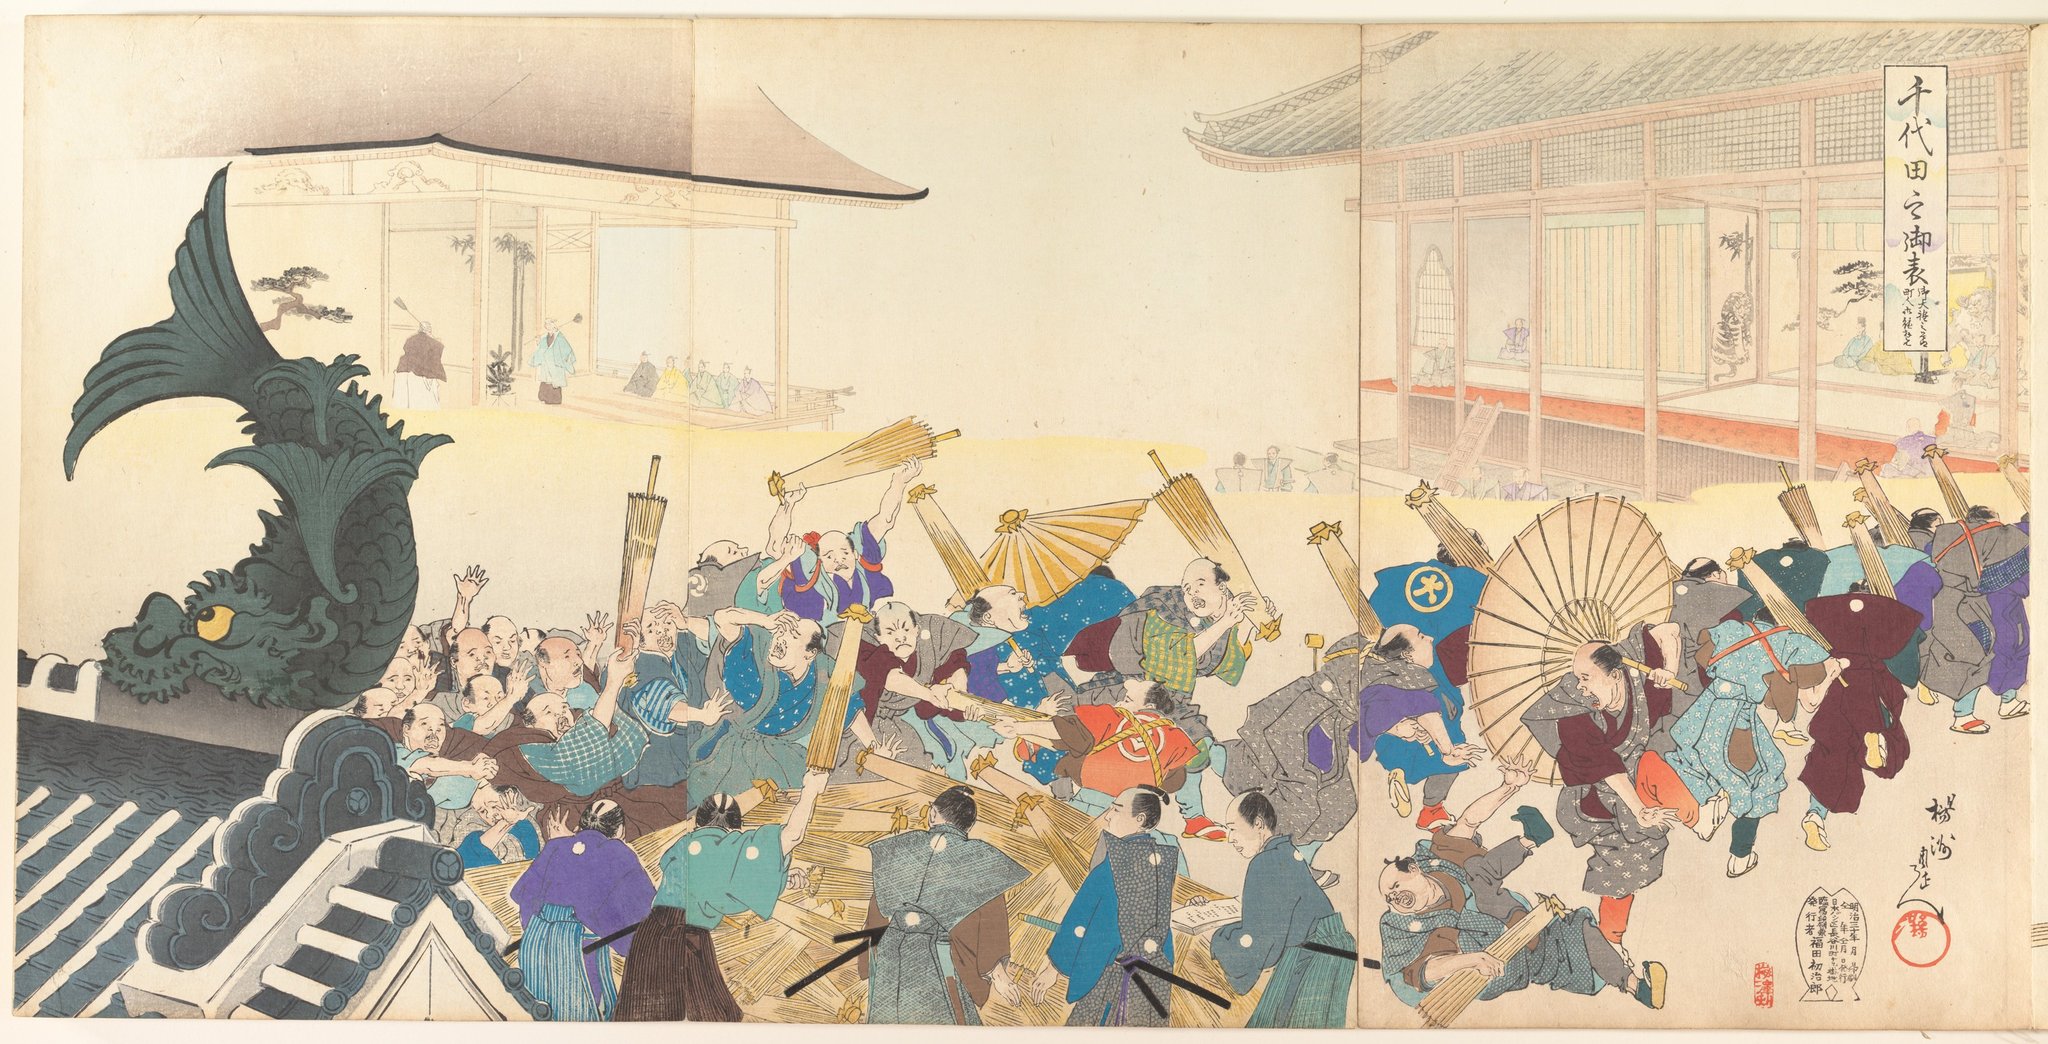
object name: print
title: Chiyoda Castle (Album of Men)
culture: japanese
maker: yōshū (hashimoto) chikanobu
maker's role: artist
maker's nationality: japanese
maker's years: 1838-1912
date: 1897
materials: ink, paper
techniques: woodblock print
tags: houses,men,fish,crowd